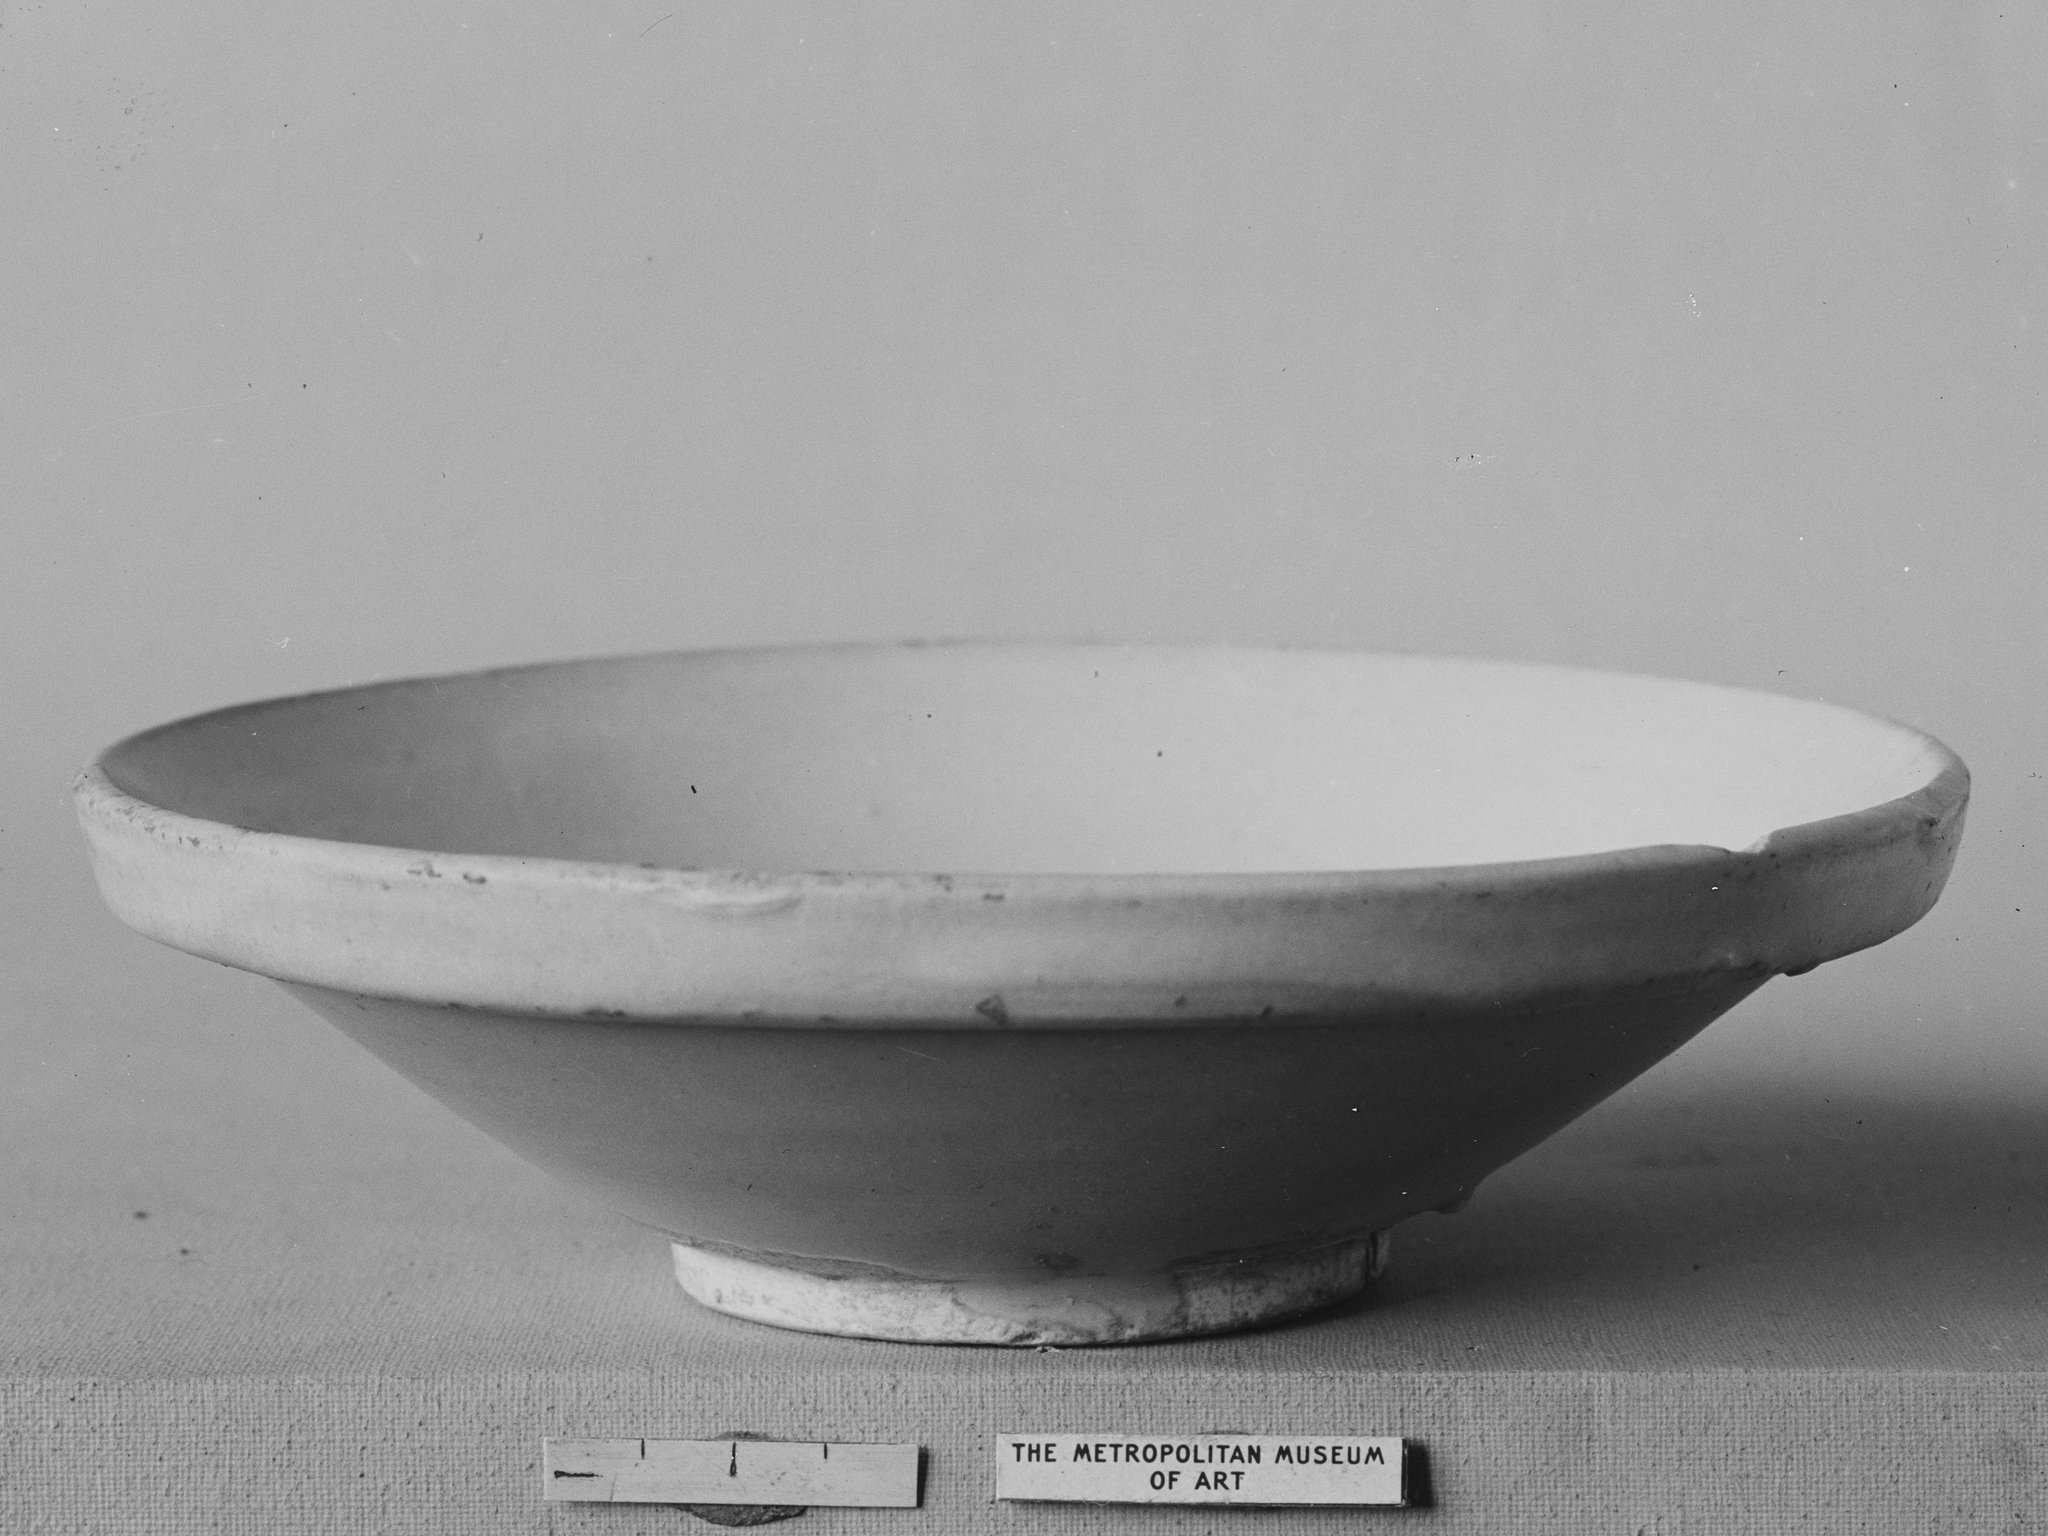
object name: saucer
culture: chinese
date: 801-900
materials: earthenware, glaze